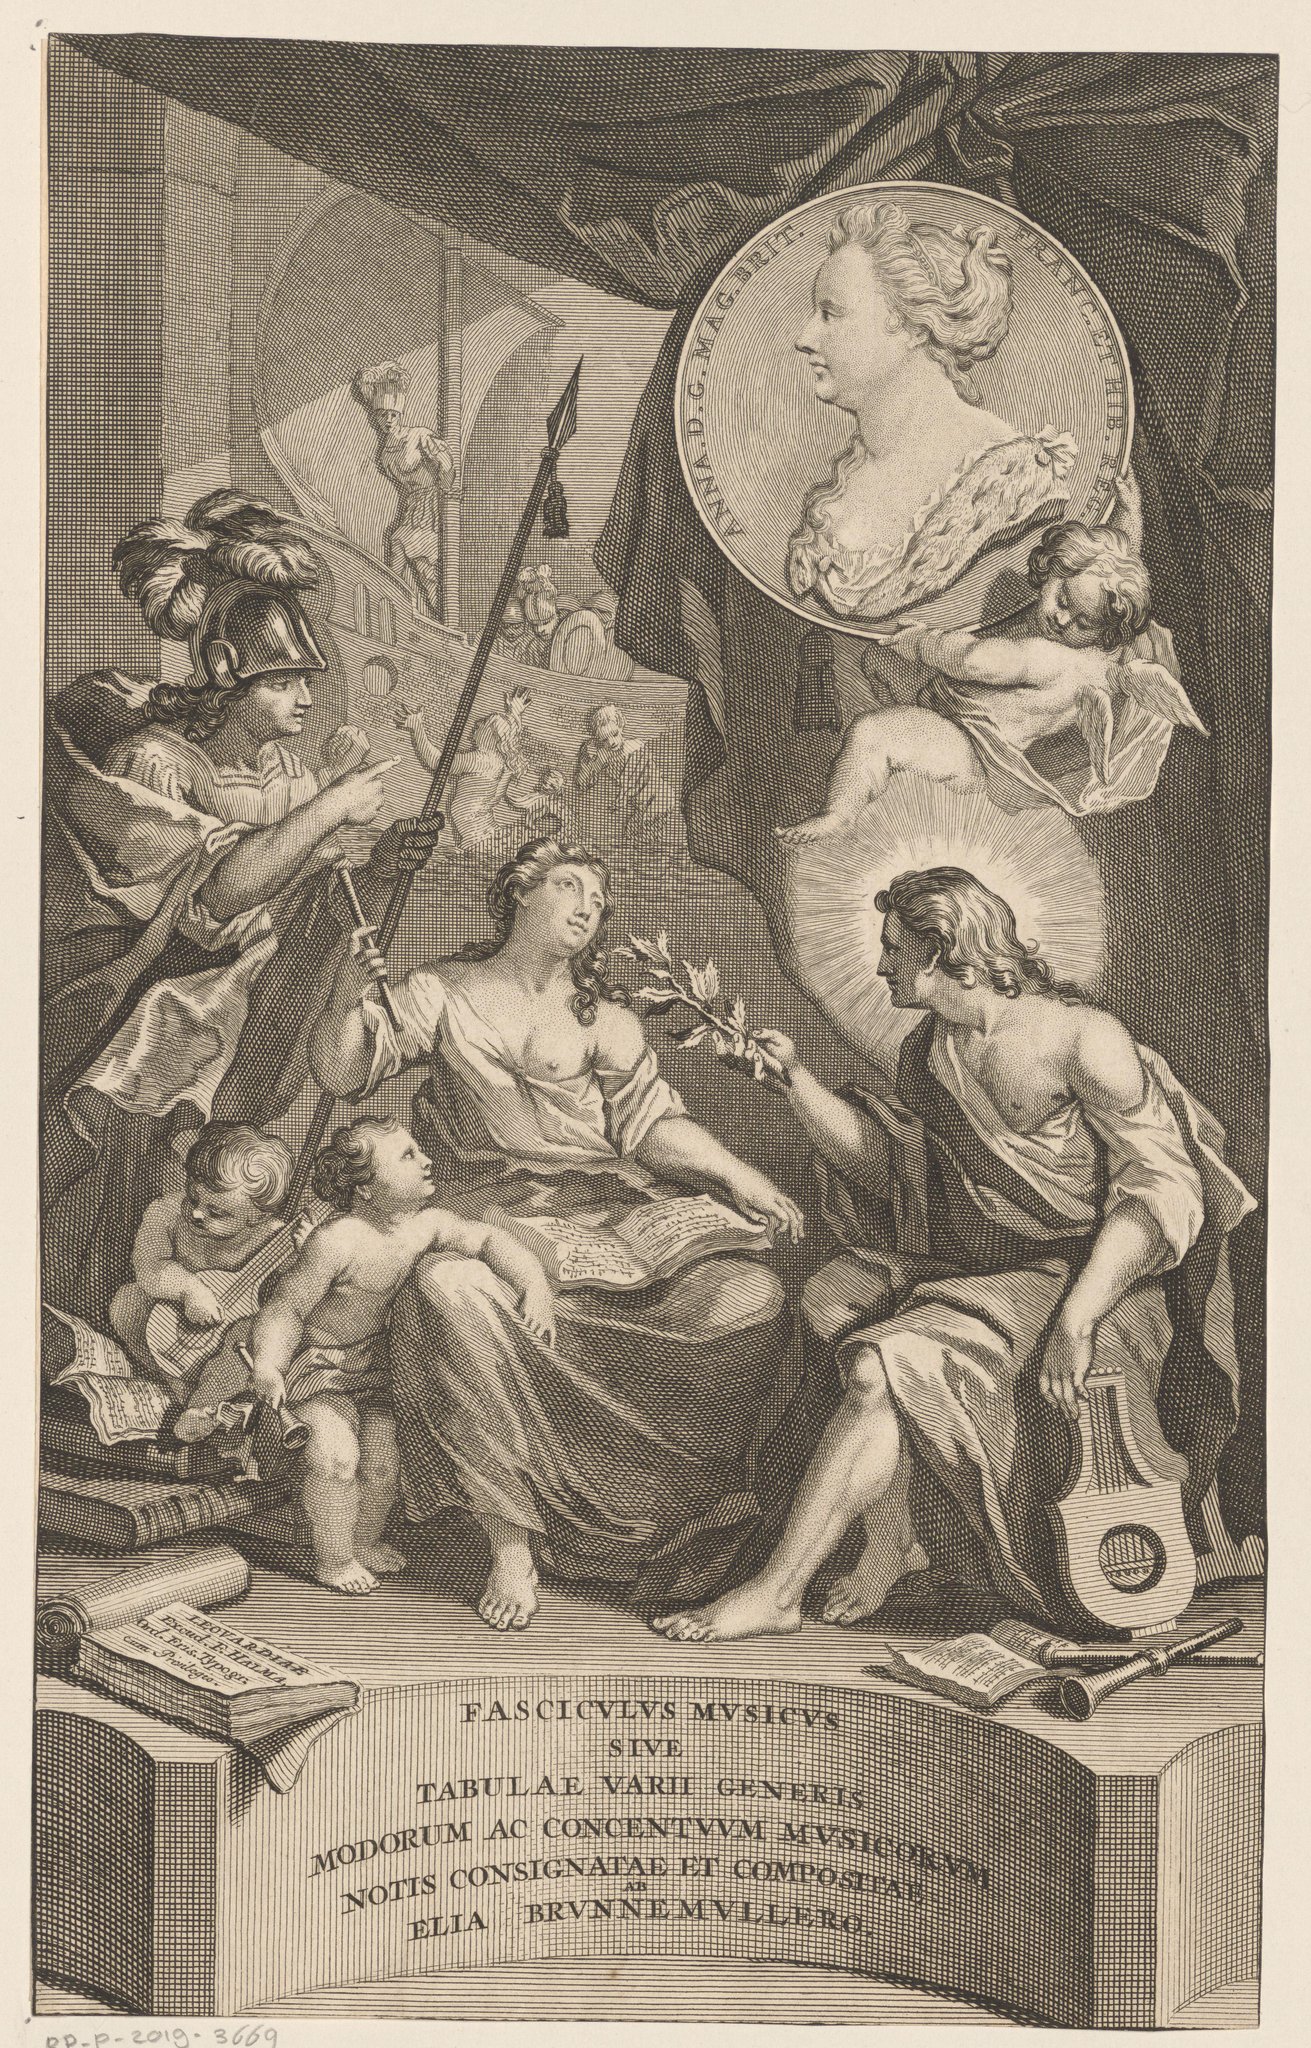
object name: titelblad, titelpagina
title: Allegorische titelpagina met de personificatie van Muziek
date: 1710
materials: paper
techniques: engraving, etching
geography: leeuwarden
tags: anna stuart (koningin van engeland en schotland), minerva as patroness, 'musica', symbolic representations, allegories and emblems ~ music; 'musica'(ripa), historical persons - bb - woman, specific aspects, allegorical aspects of apollo; apollo as patron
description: Prent gebruikt als titelpagina voor: Bronnemüller, Elias. Fasciculus musicus sive tabulae varii generis modorum ac concentuum musicorum. Leeuwarden: François Halma, 1710.